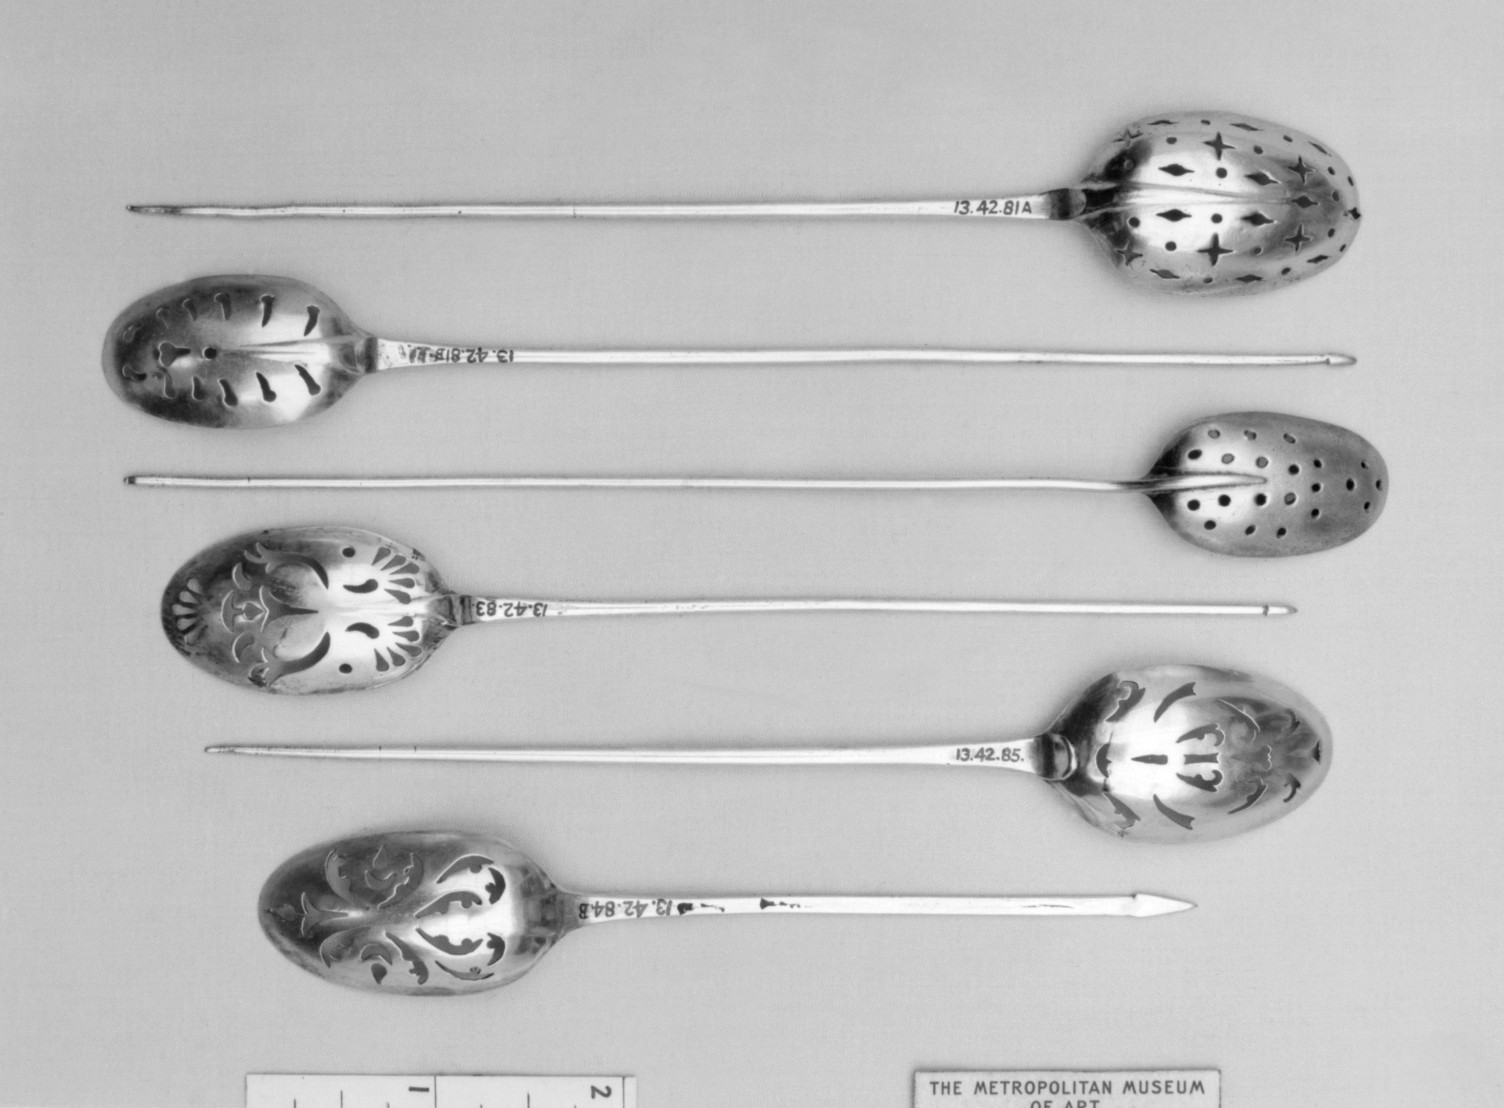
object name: strainer spoon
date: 1701-1800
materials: silver